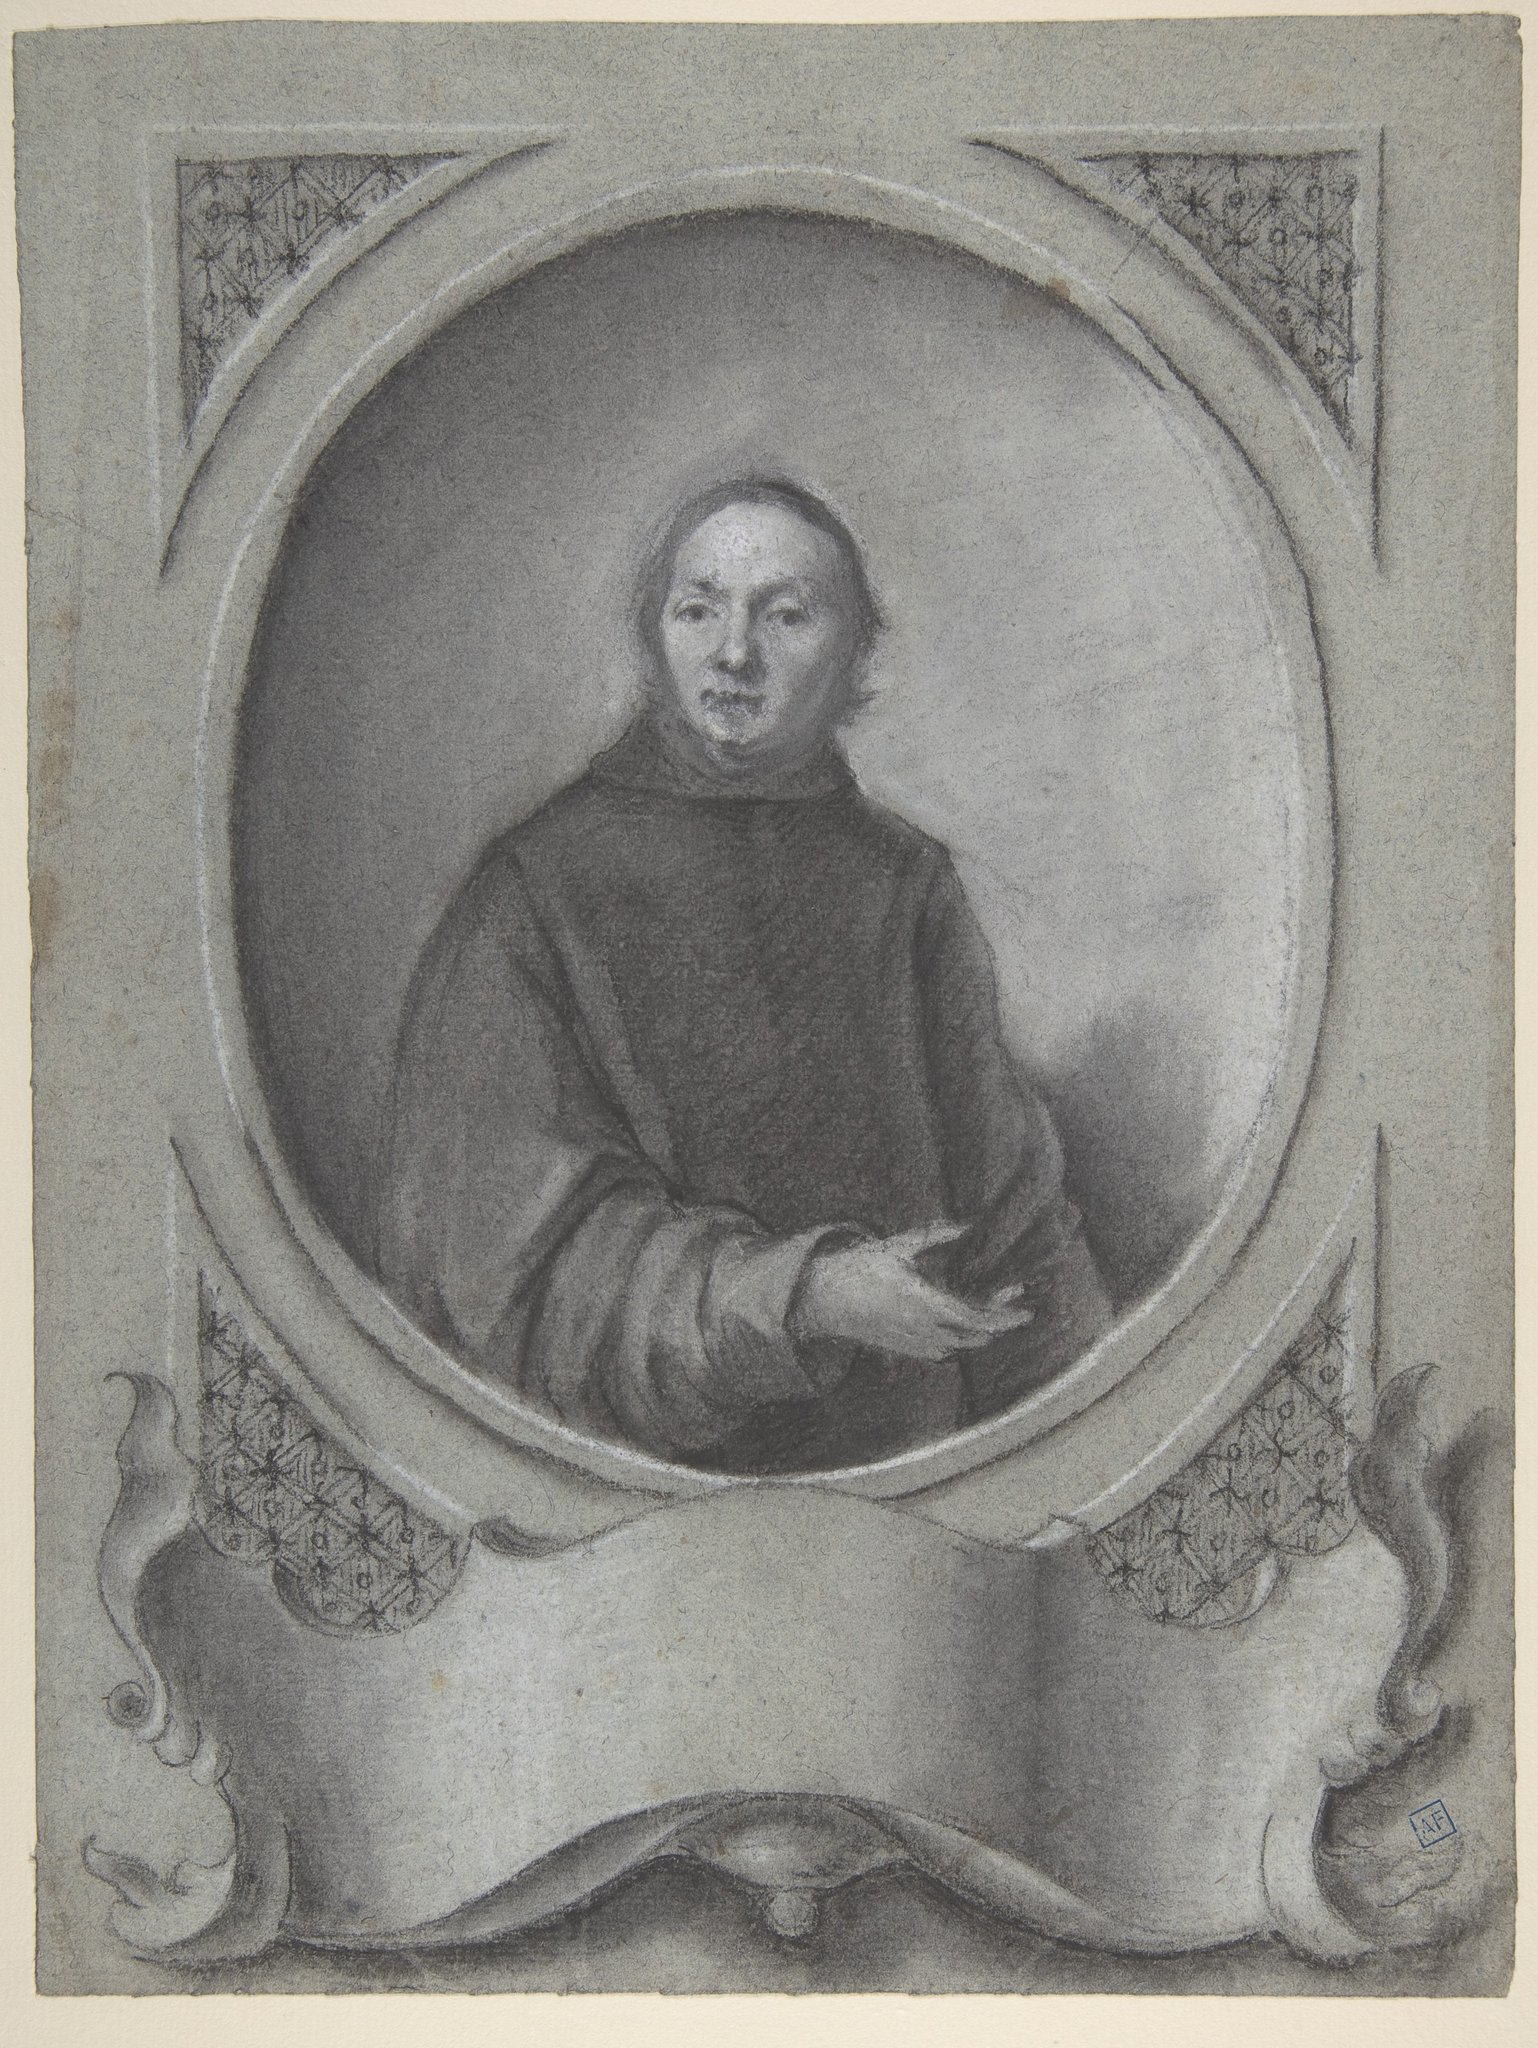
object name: drawing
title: Portrait of a Man in a Monastic Habit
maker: bartolommeo nazari (nazzari)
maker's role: artist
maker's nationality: italian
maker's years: 1699-1758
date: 1699-1758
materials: chalk, paper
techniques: highlighting, stumping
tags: men,portraits